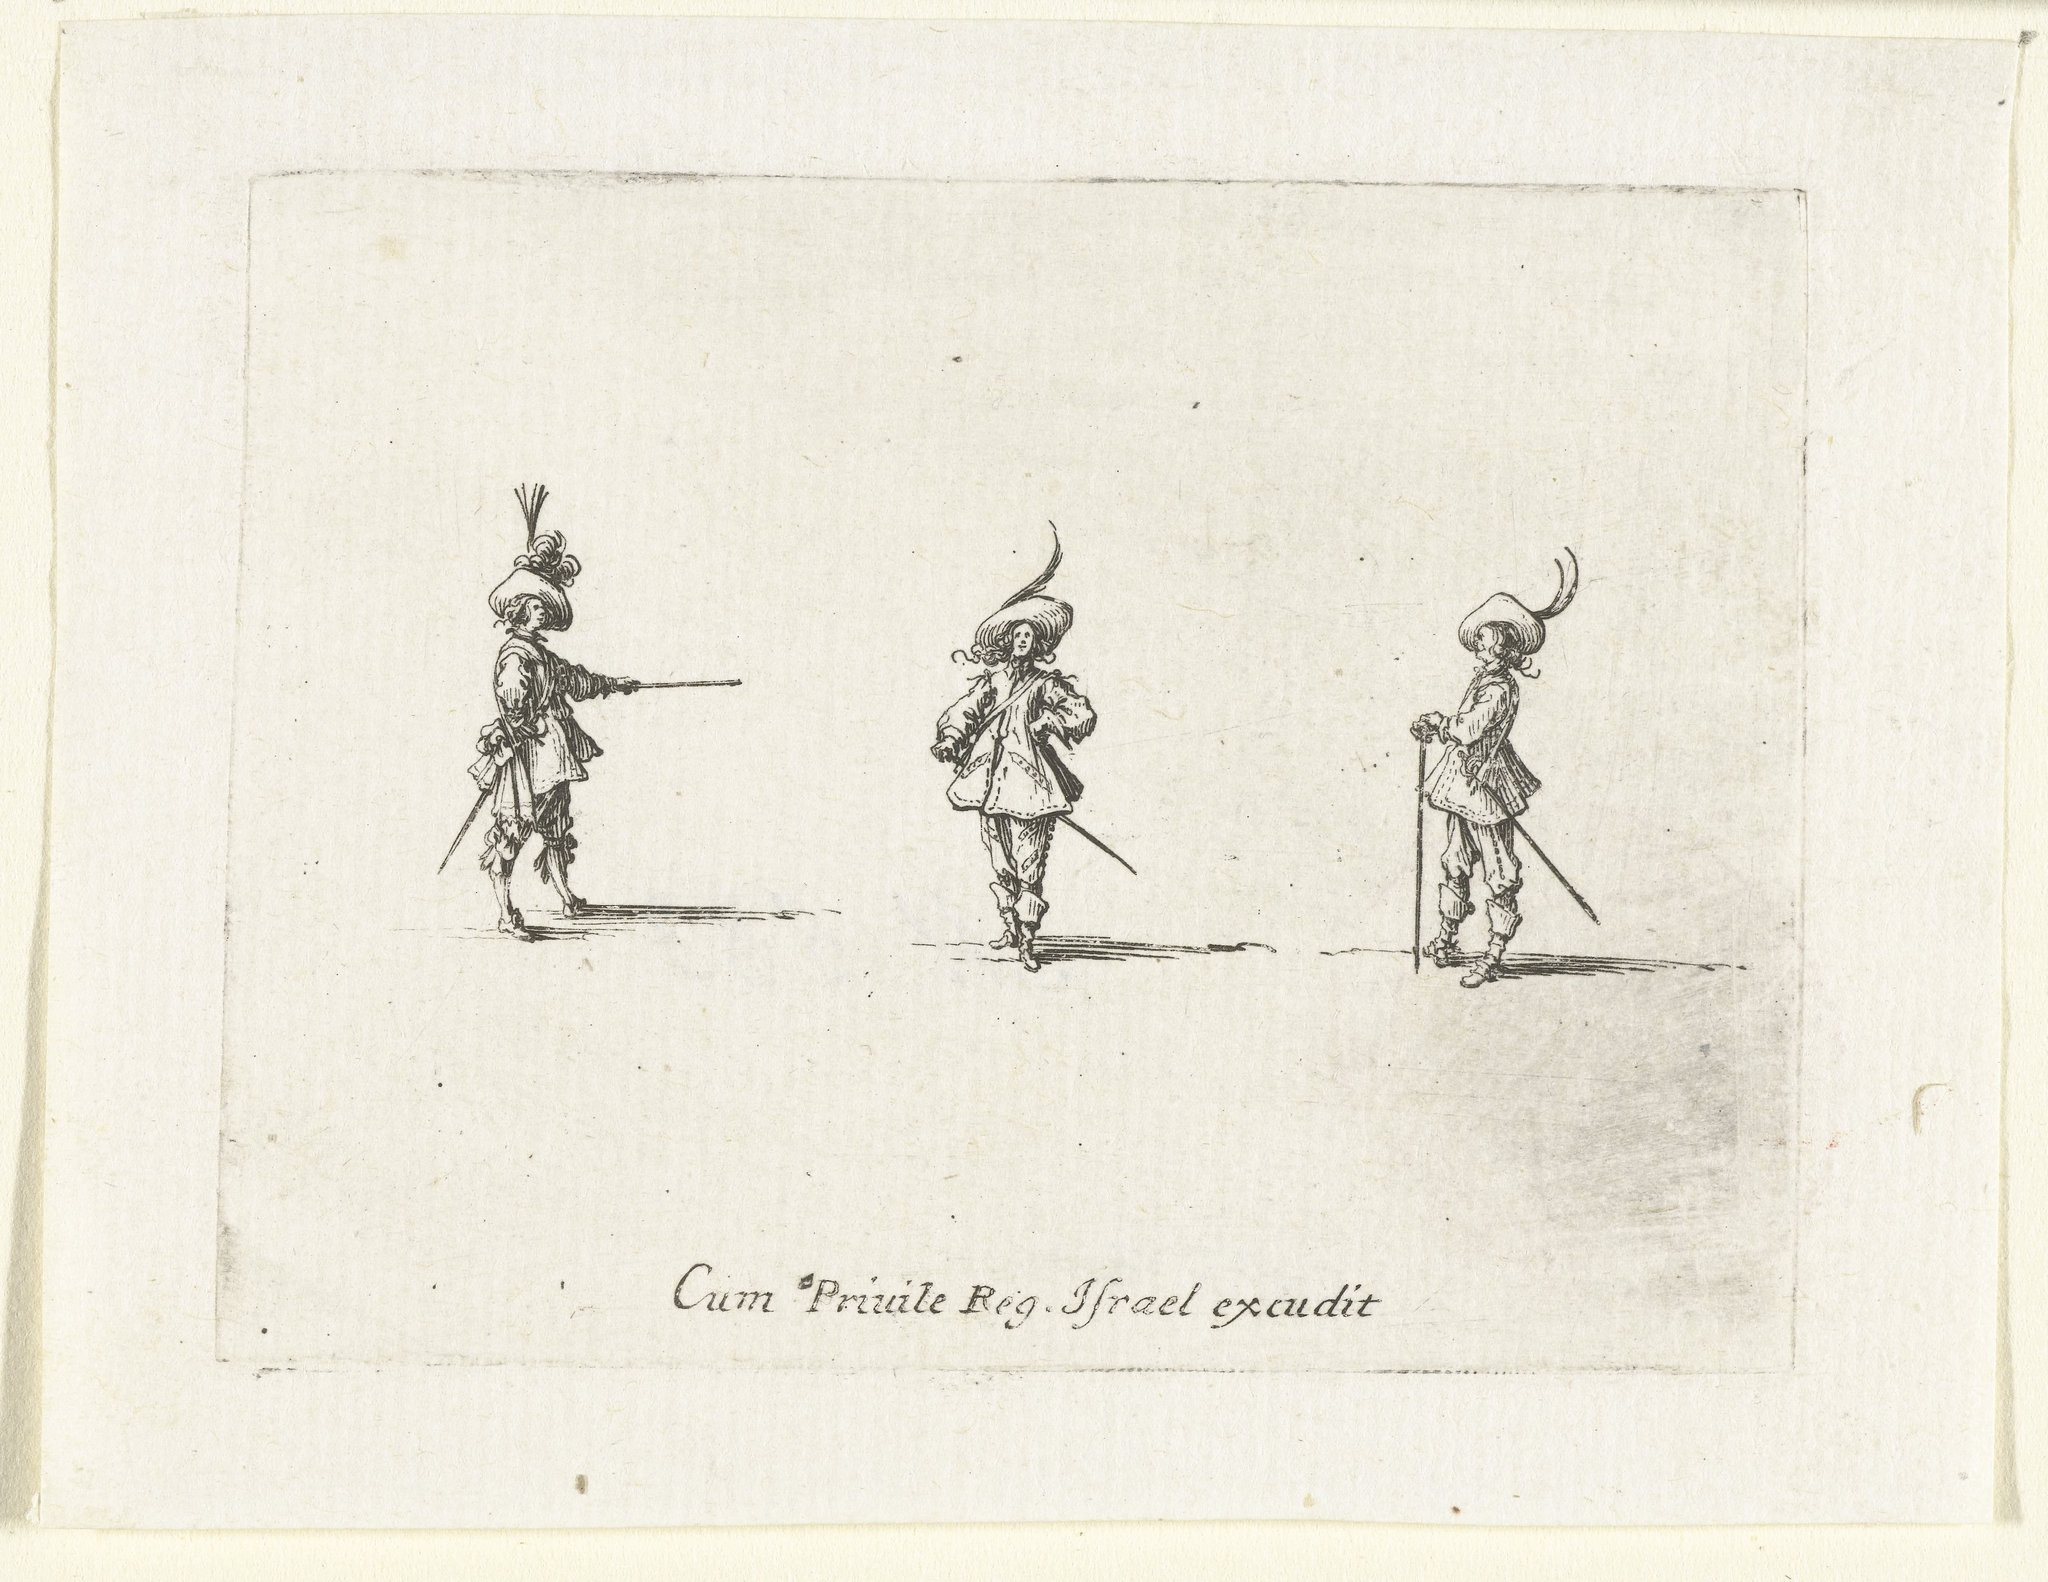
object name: print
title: Militaire exercities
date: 1635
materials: paper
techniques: etching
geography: nancy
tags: private soldier, military instruction, officer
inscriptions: collector's mark: Lugt 240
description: Links een officier, van opzij gezien, die zijn aanvoerdersstaf recht voor zich uit houdt. In het midden een soldaat, van voren gezien, zonder wapen. Rechts een soldaat, van opzij gezien, leunend op een stok of staf. Deze prent is onderdeel van een serie van 12 (13 incl. titelprent) prenten met voorstellingen van militaire (wapen)exercities. Op de meeste van die prenten staan drie soldaten in verschillende houdingen met een bepaald wapen of instrument.